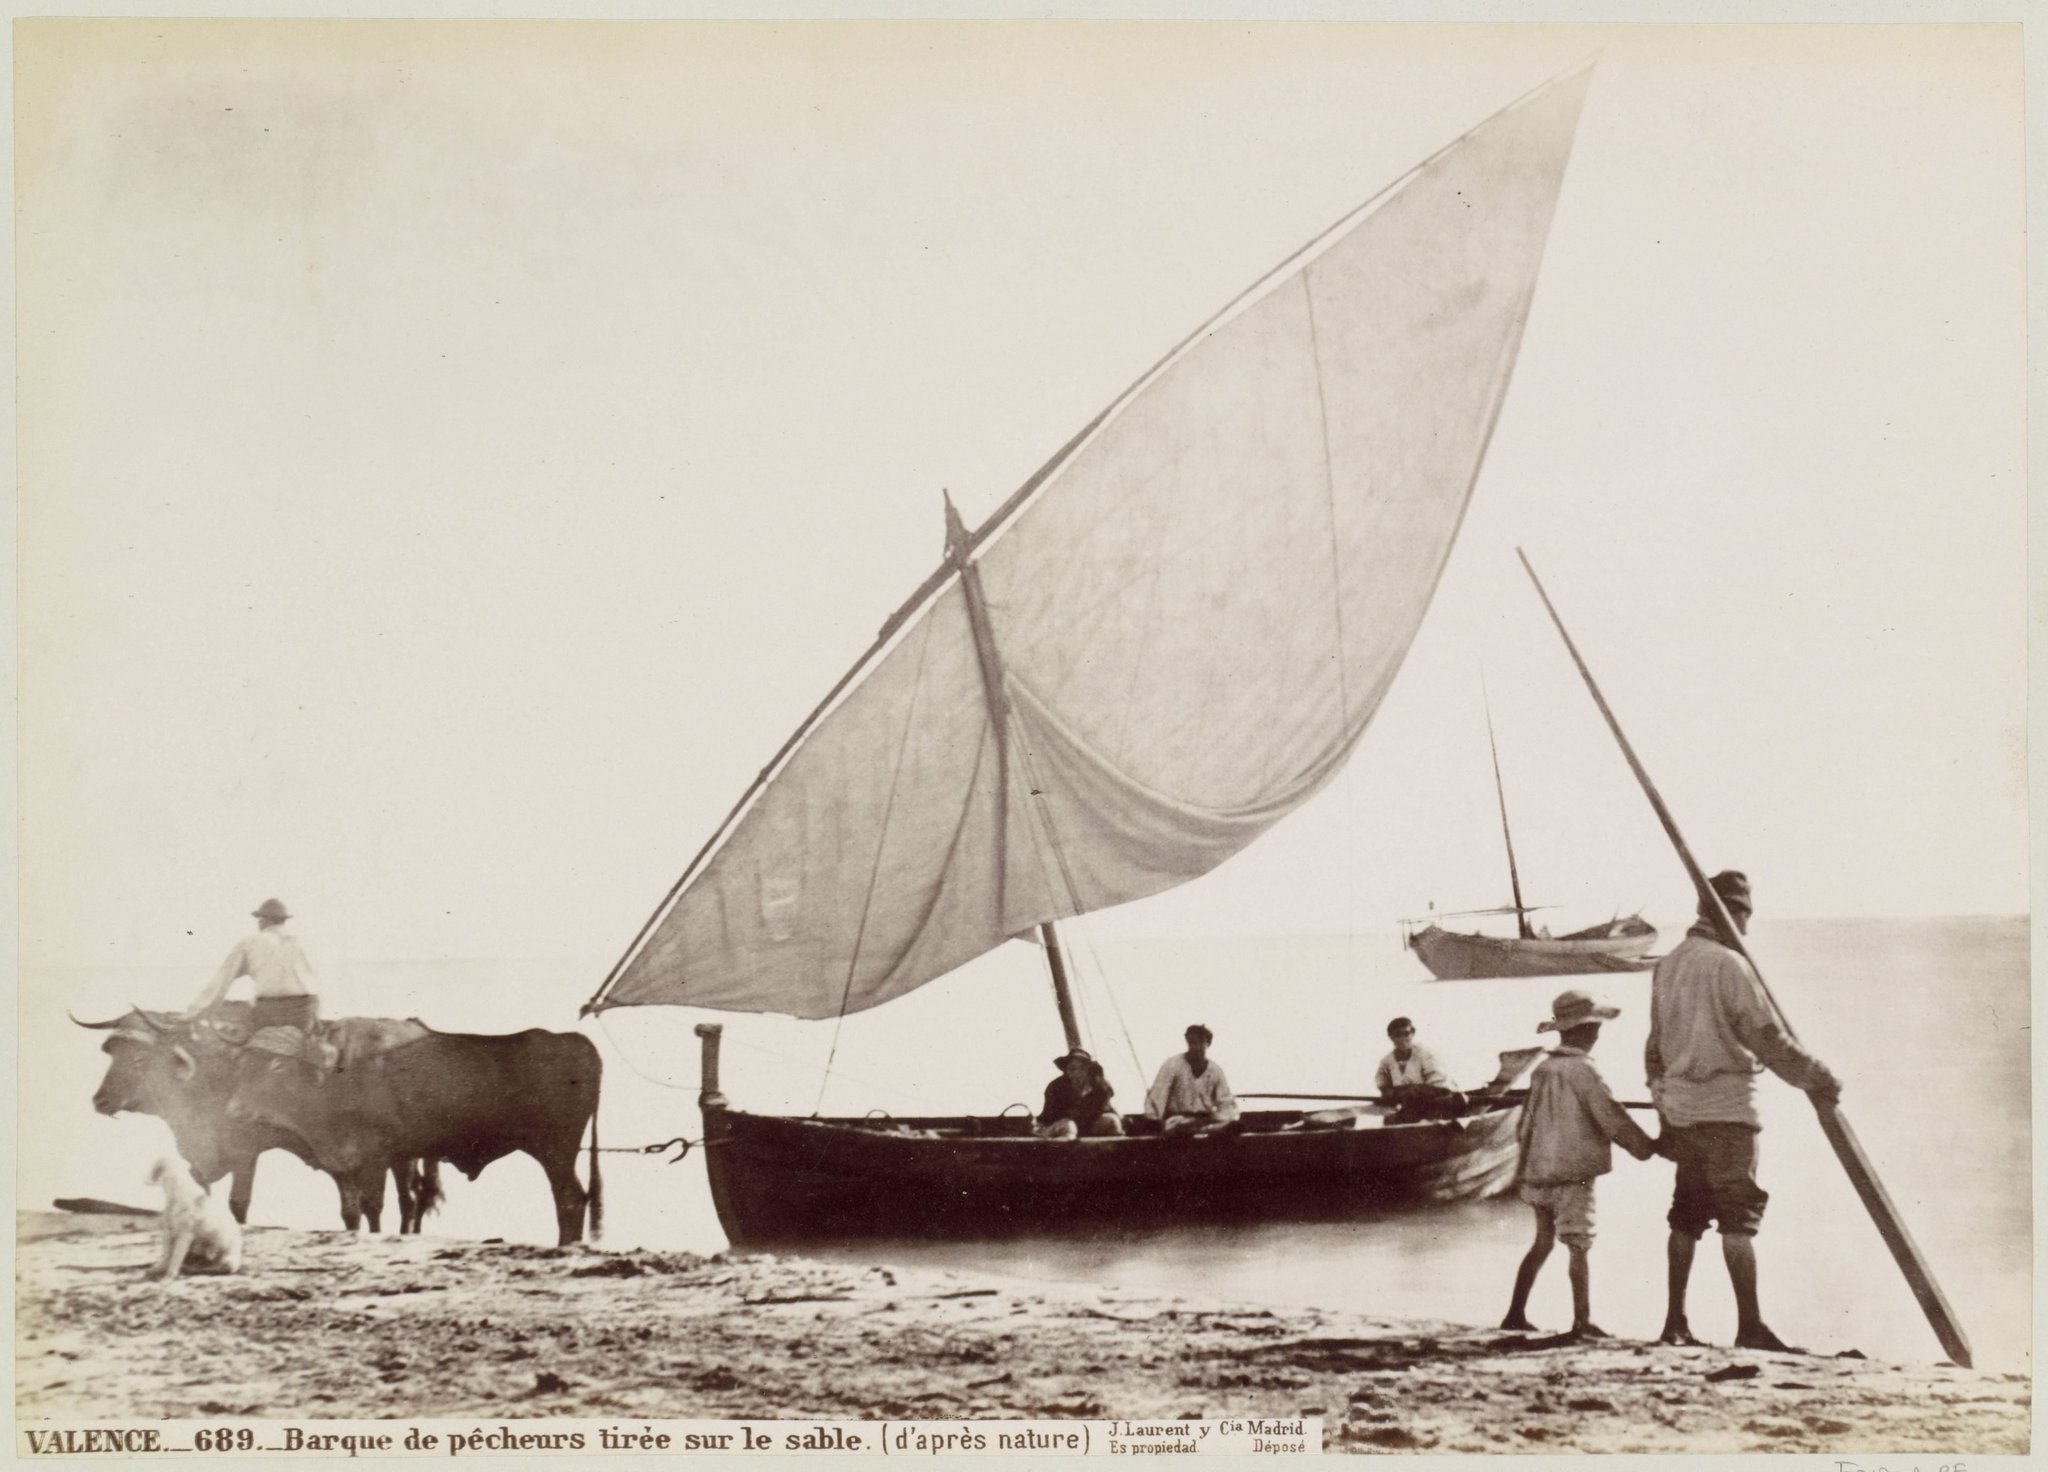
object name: photograph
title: VALENCE.- Barque de pêcheurs tirée sur le sable. (d'apès nature)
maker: juan laurent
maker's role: publisher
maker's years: 1816-1896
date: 1857-1880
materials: cardboard, paper, photographic support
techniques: albumen print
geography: valencia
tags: sailing-ship, sailing-boat, ox, fisherman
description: Onderdeel van Reisalbum met foto's van bezienswaardigheden in Spanje en Marokko.